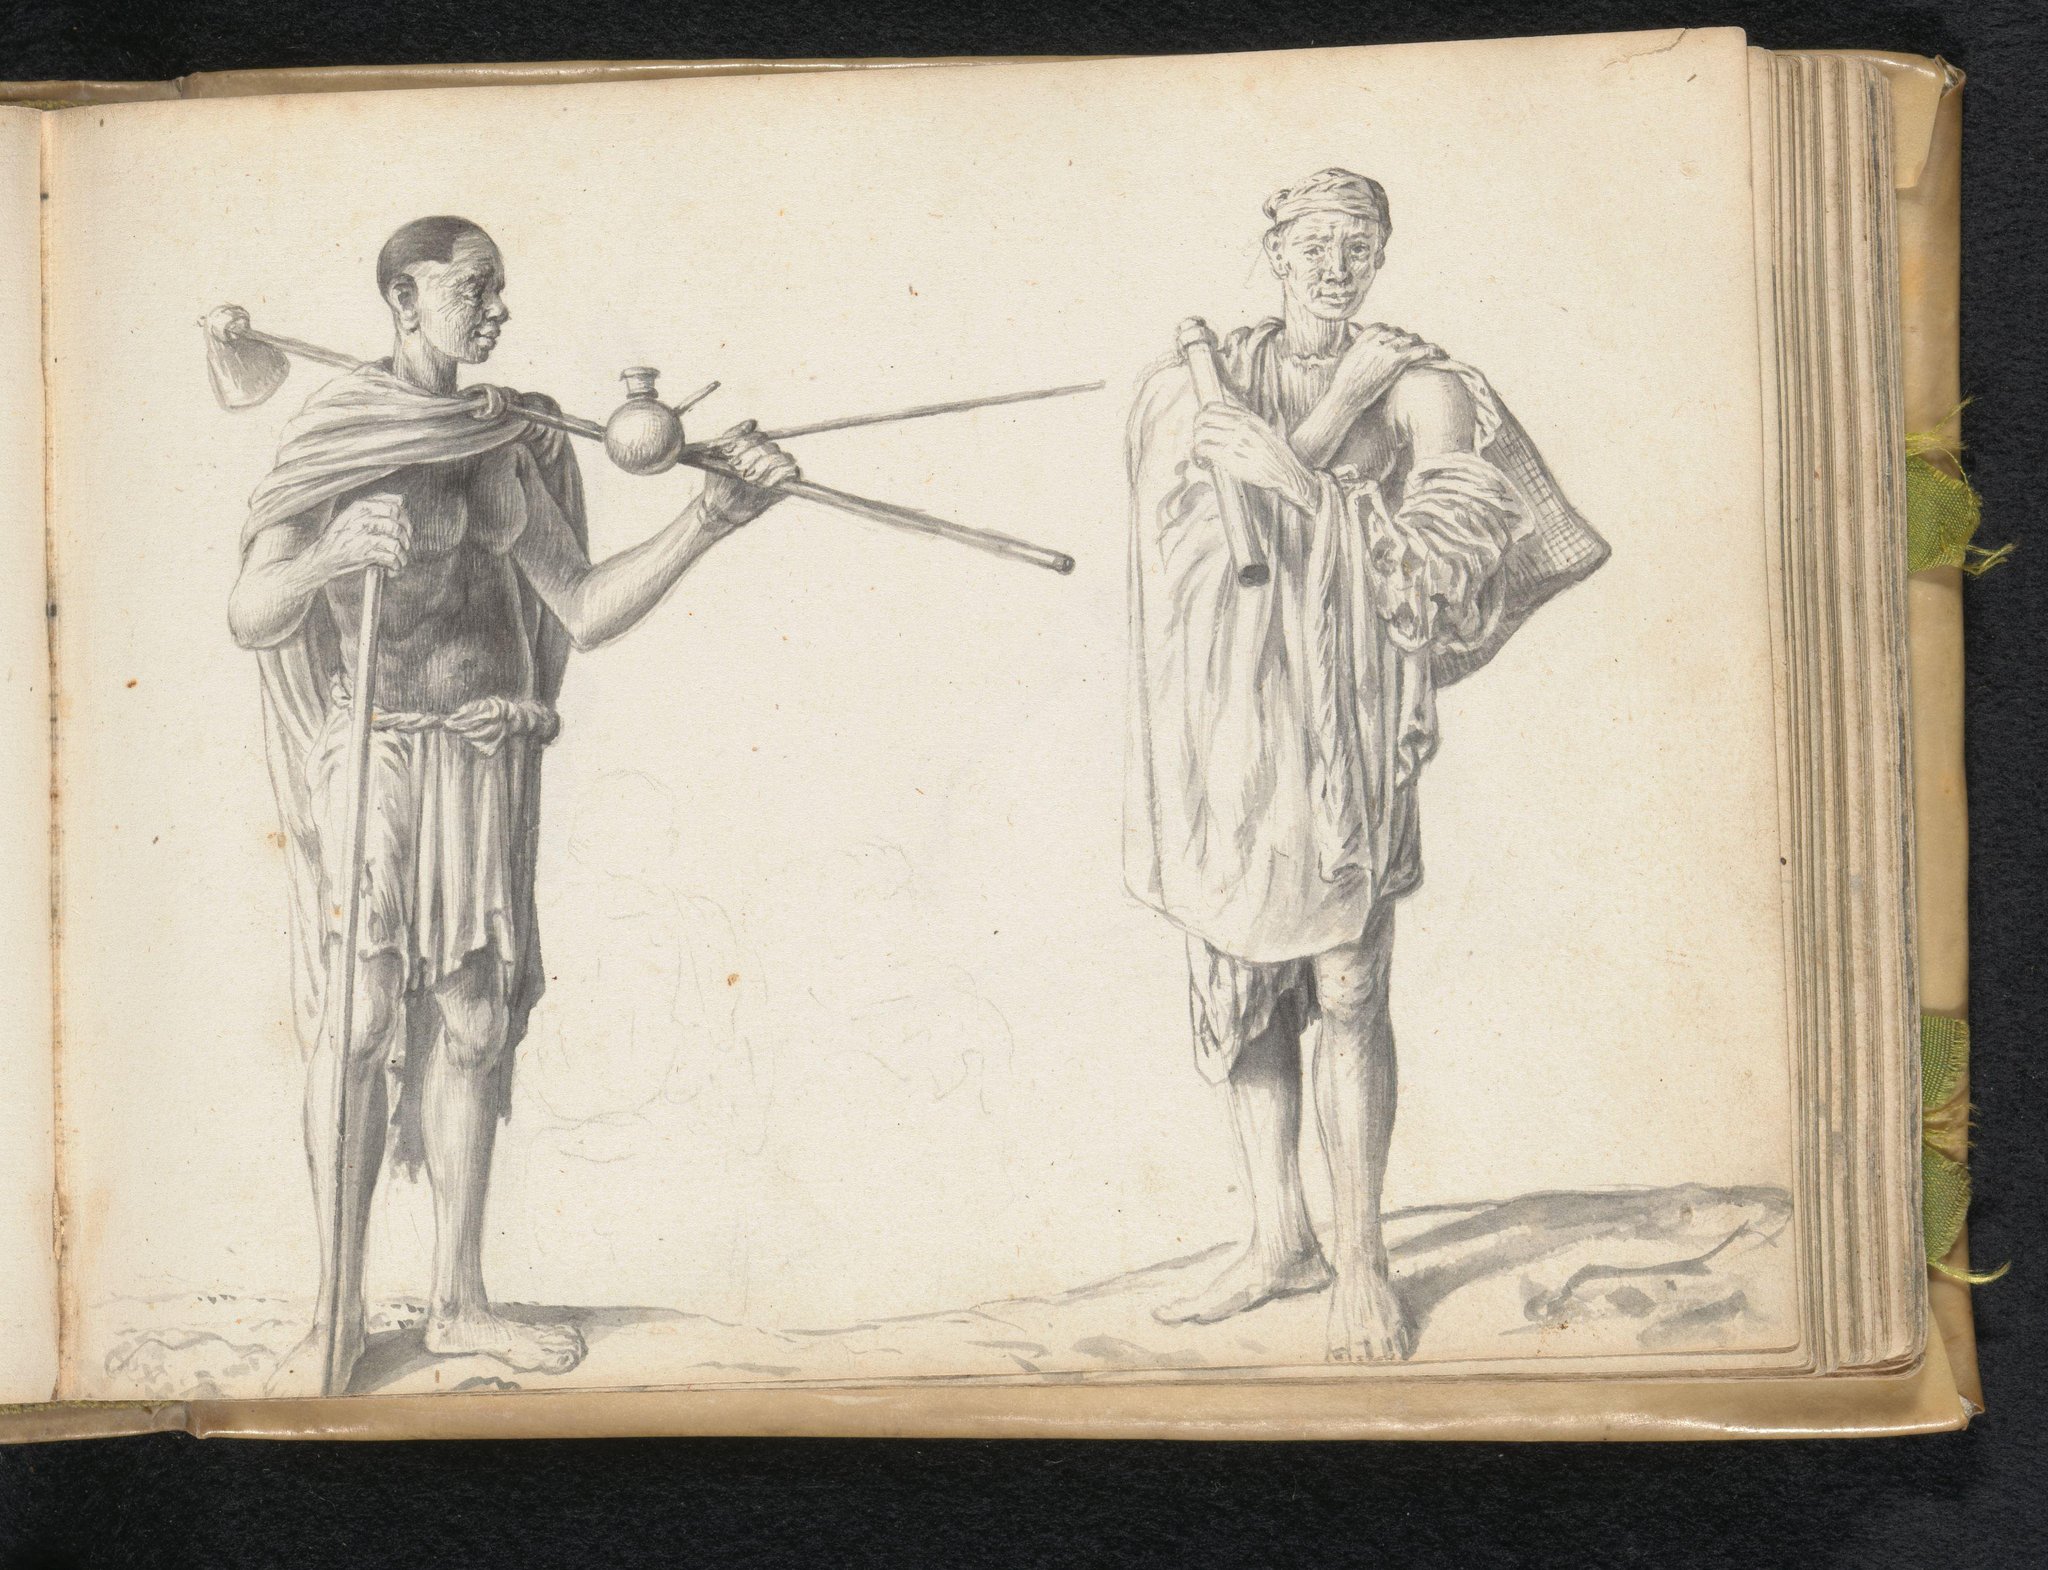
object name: sketchbook leaf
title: Two labourers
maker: esaias boursse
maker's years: 1631-1672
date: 1662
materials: ink, paper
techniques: brush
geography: sri lanka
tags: agricultural implements: hoe, 41d232(...) skirt (lungi), head-gear (with name), wind instruments, asiatic races and peoples: indians, sri lanka